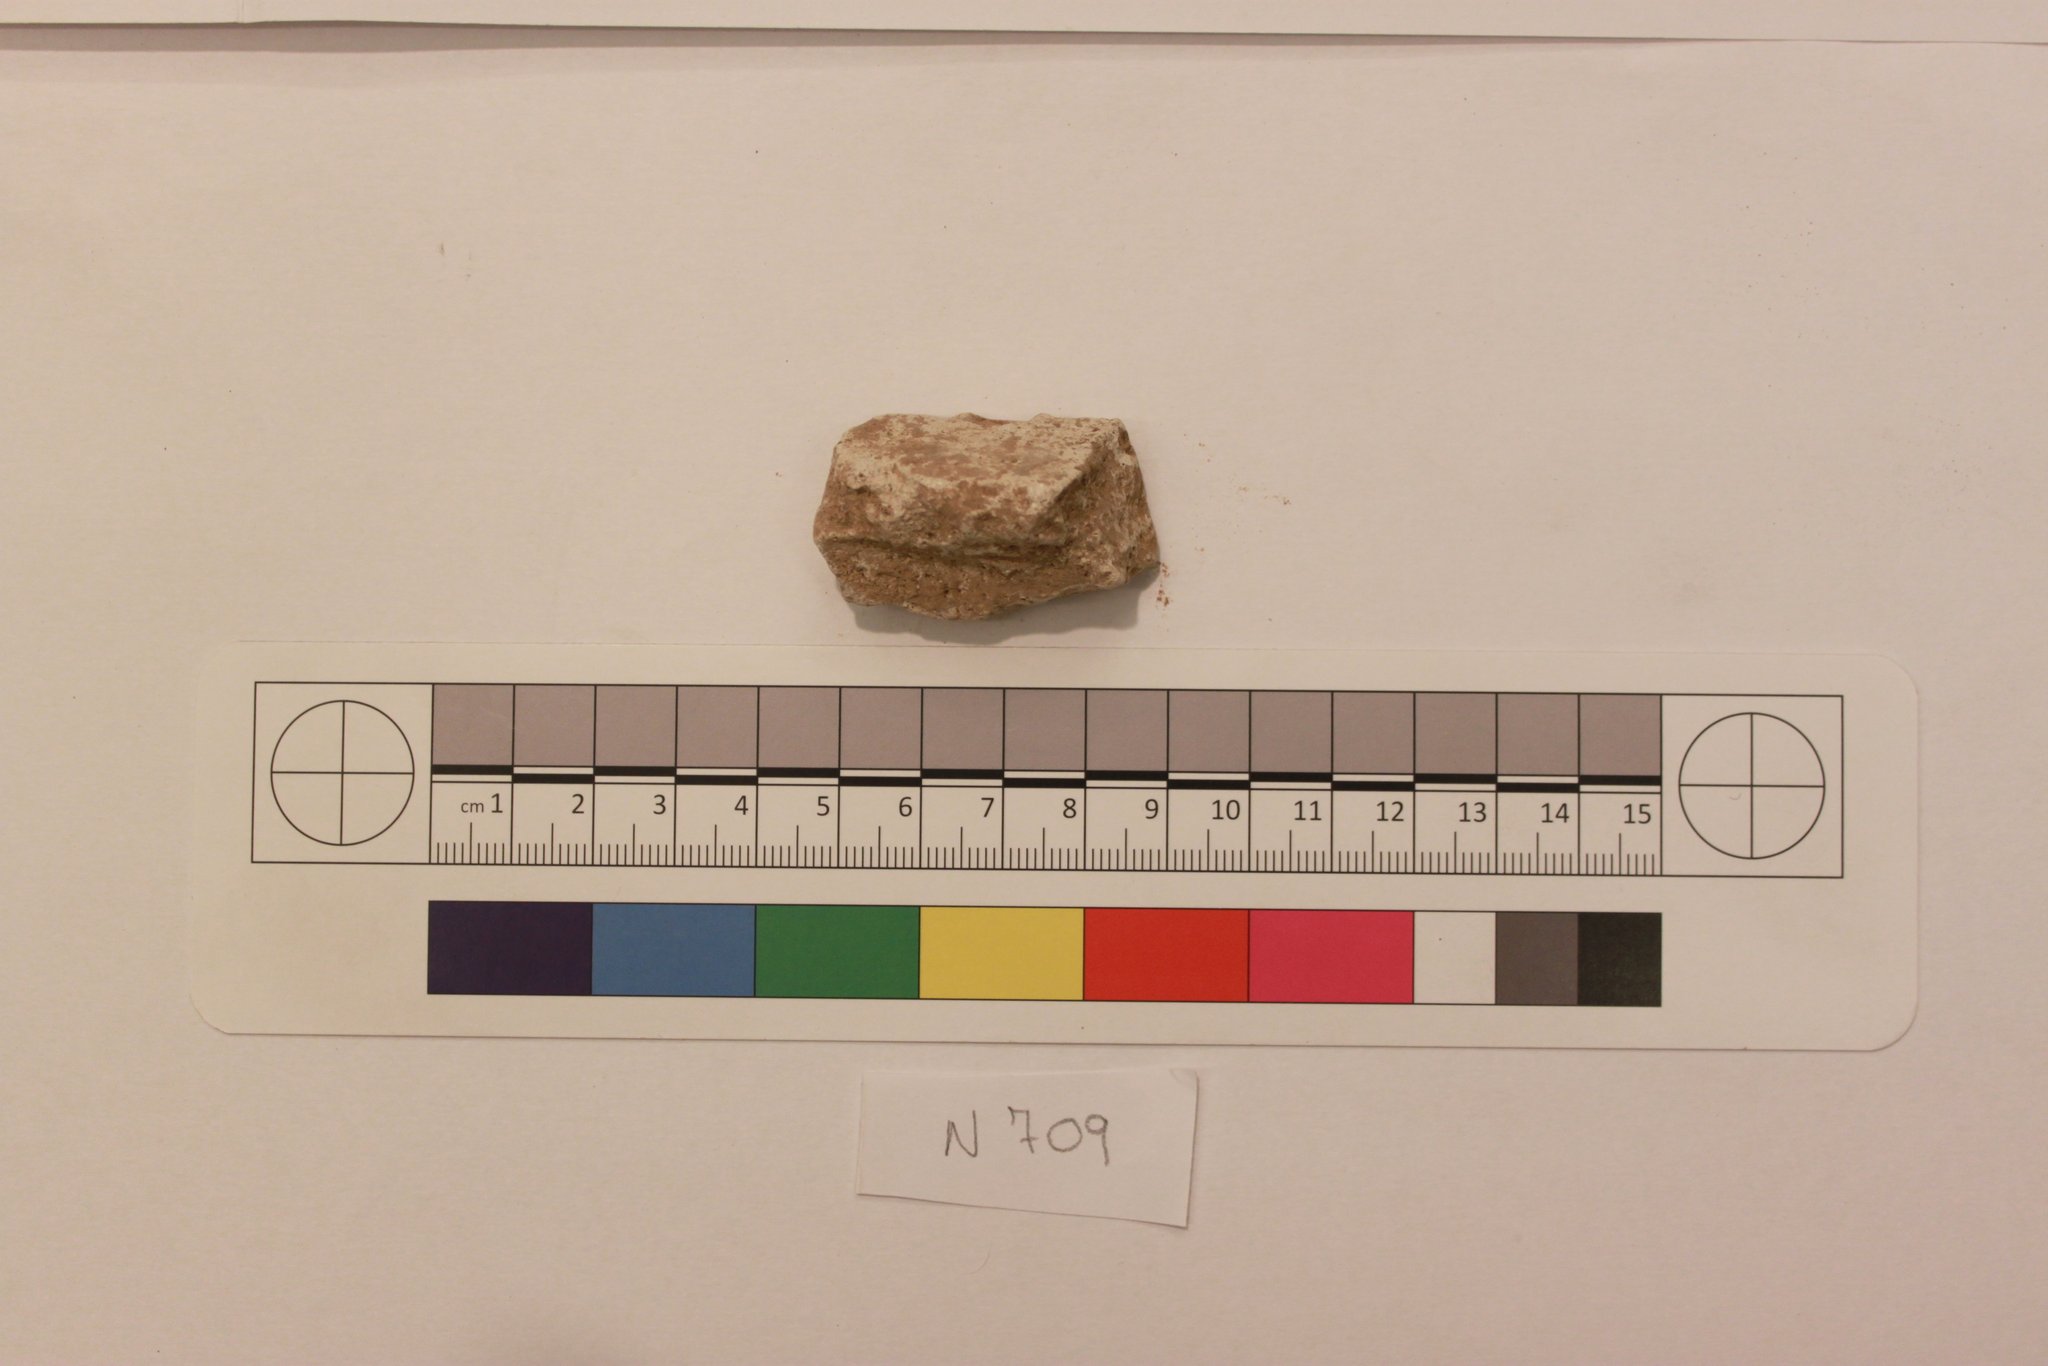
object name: fragment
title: Stucco Fragment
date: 701-1200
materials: plaster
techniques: carving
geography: iran